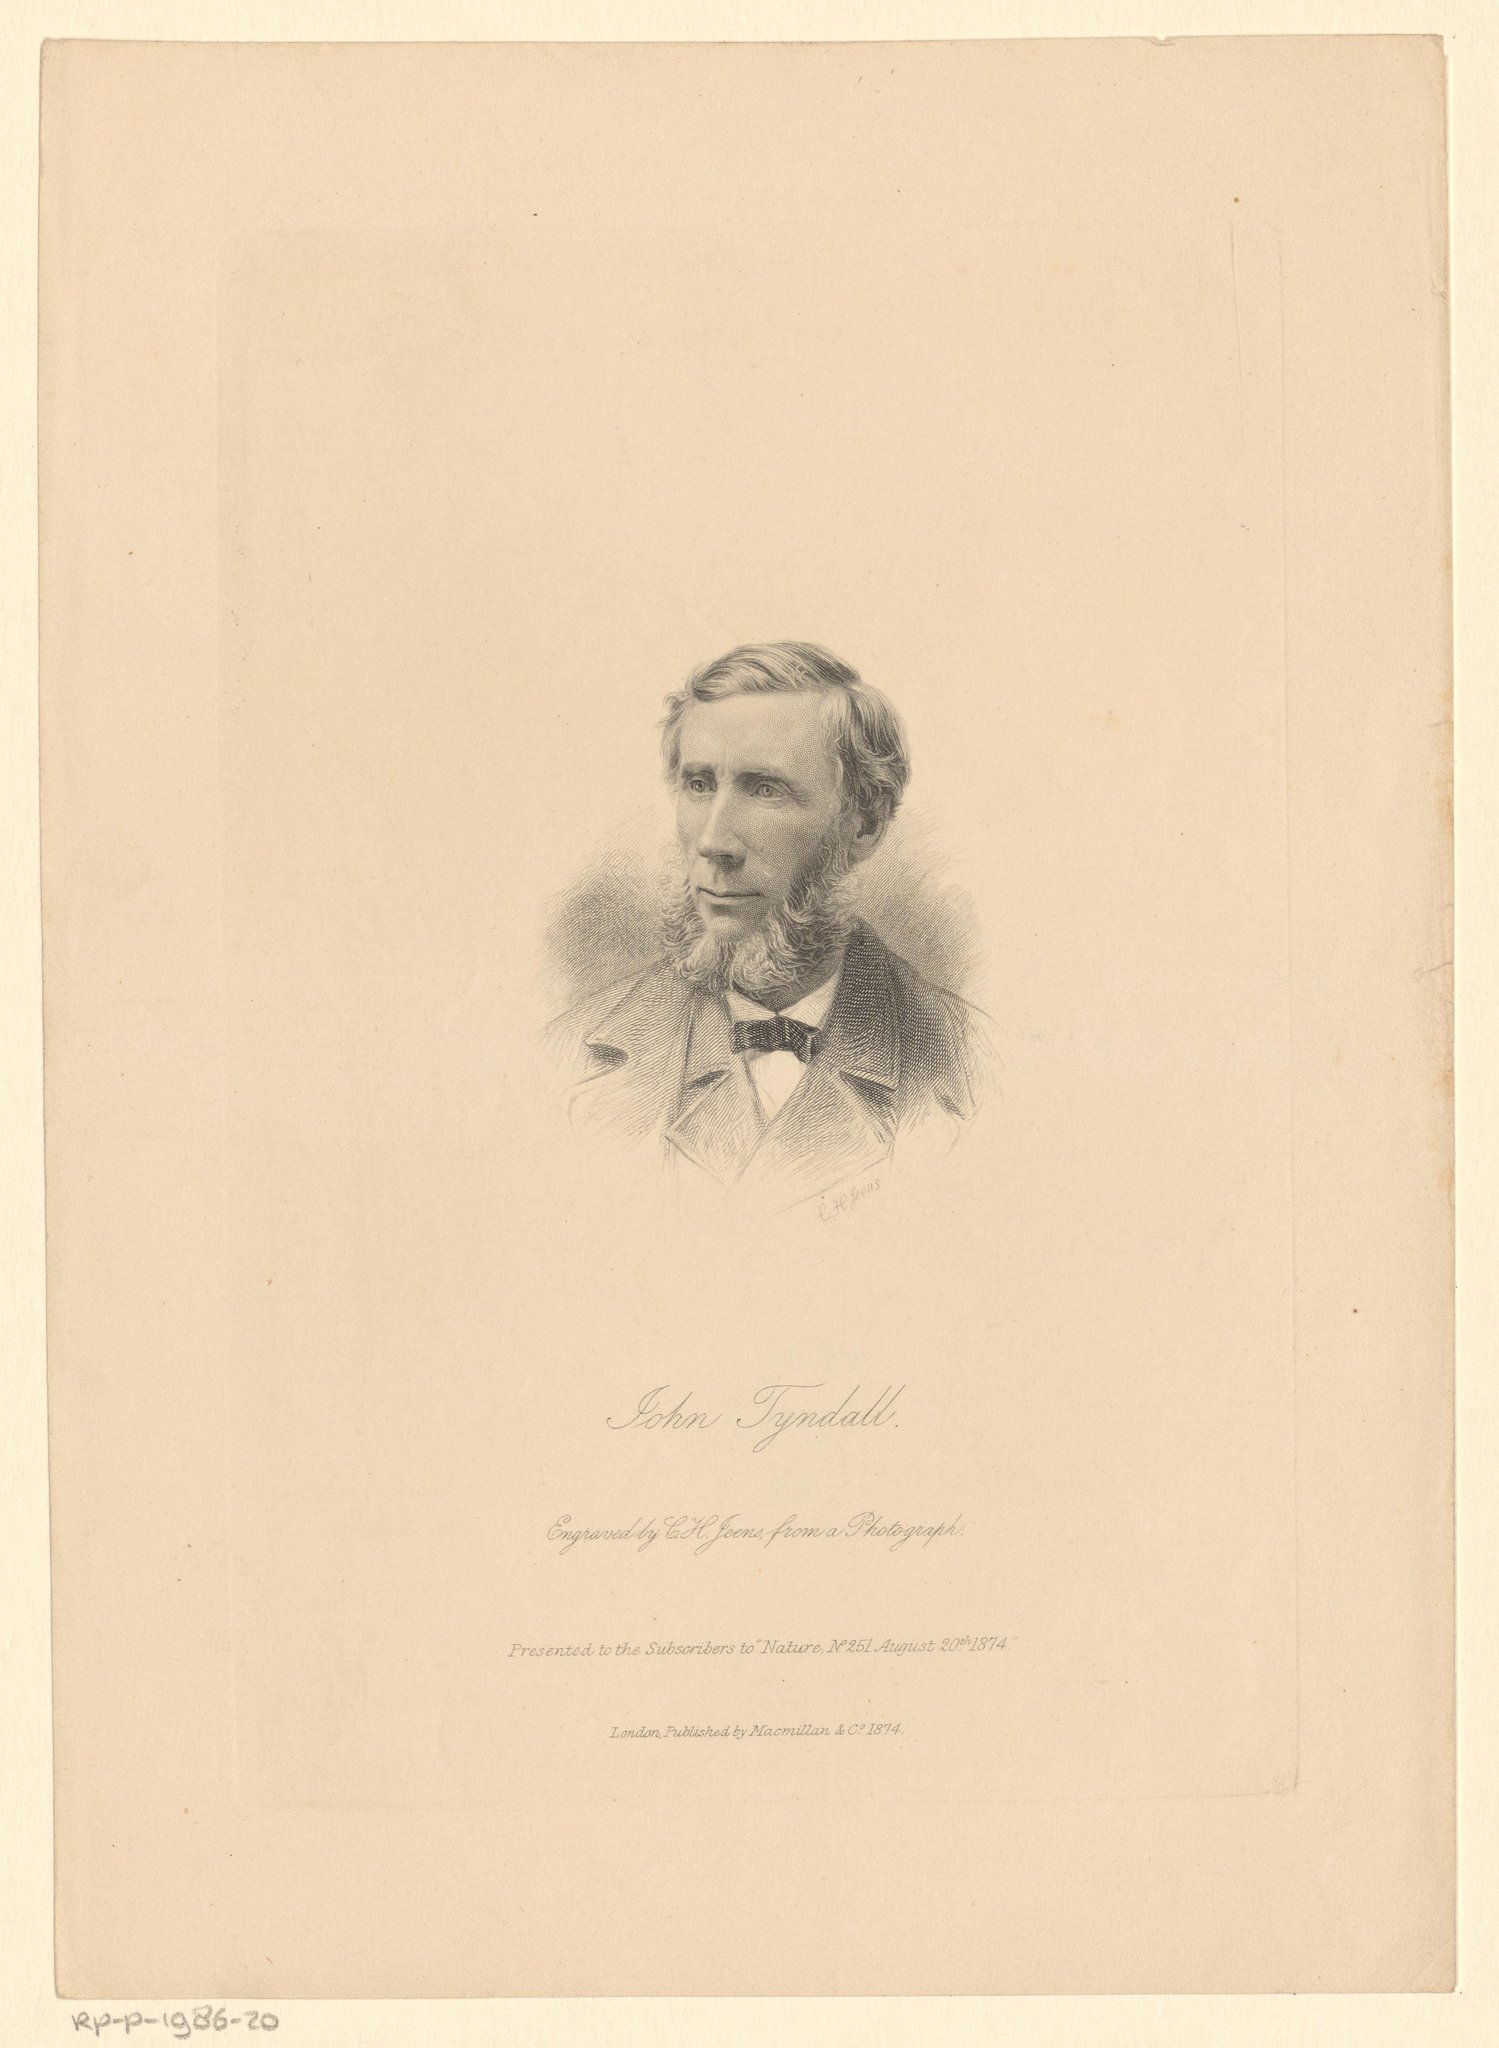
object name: print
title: Portret van John Tyndall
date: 1874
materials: paper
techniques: engraving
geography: london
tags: scholar, philosopher, historical persons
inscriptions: collector's mark: Lugt 2228, collector's mark: Lugt 2760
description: Prent uit: Nature (1874), nr. 251, 20 augustus 1874.